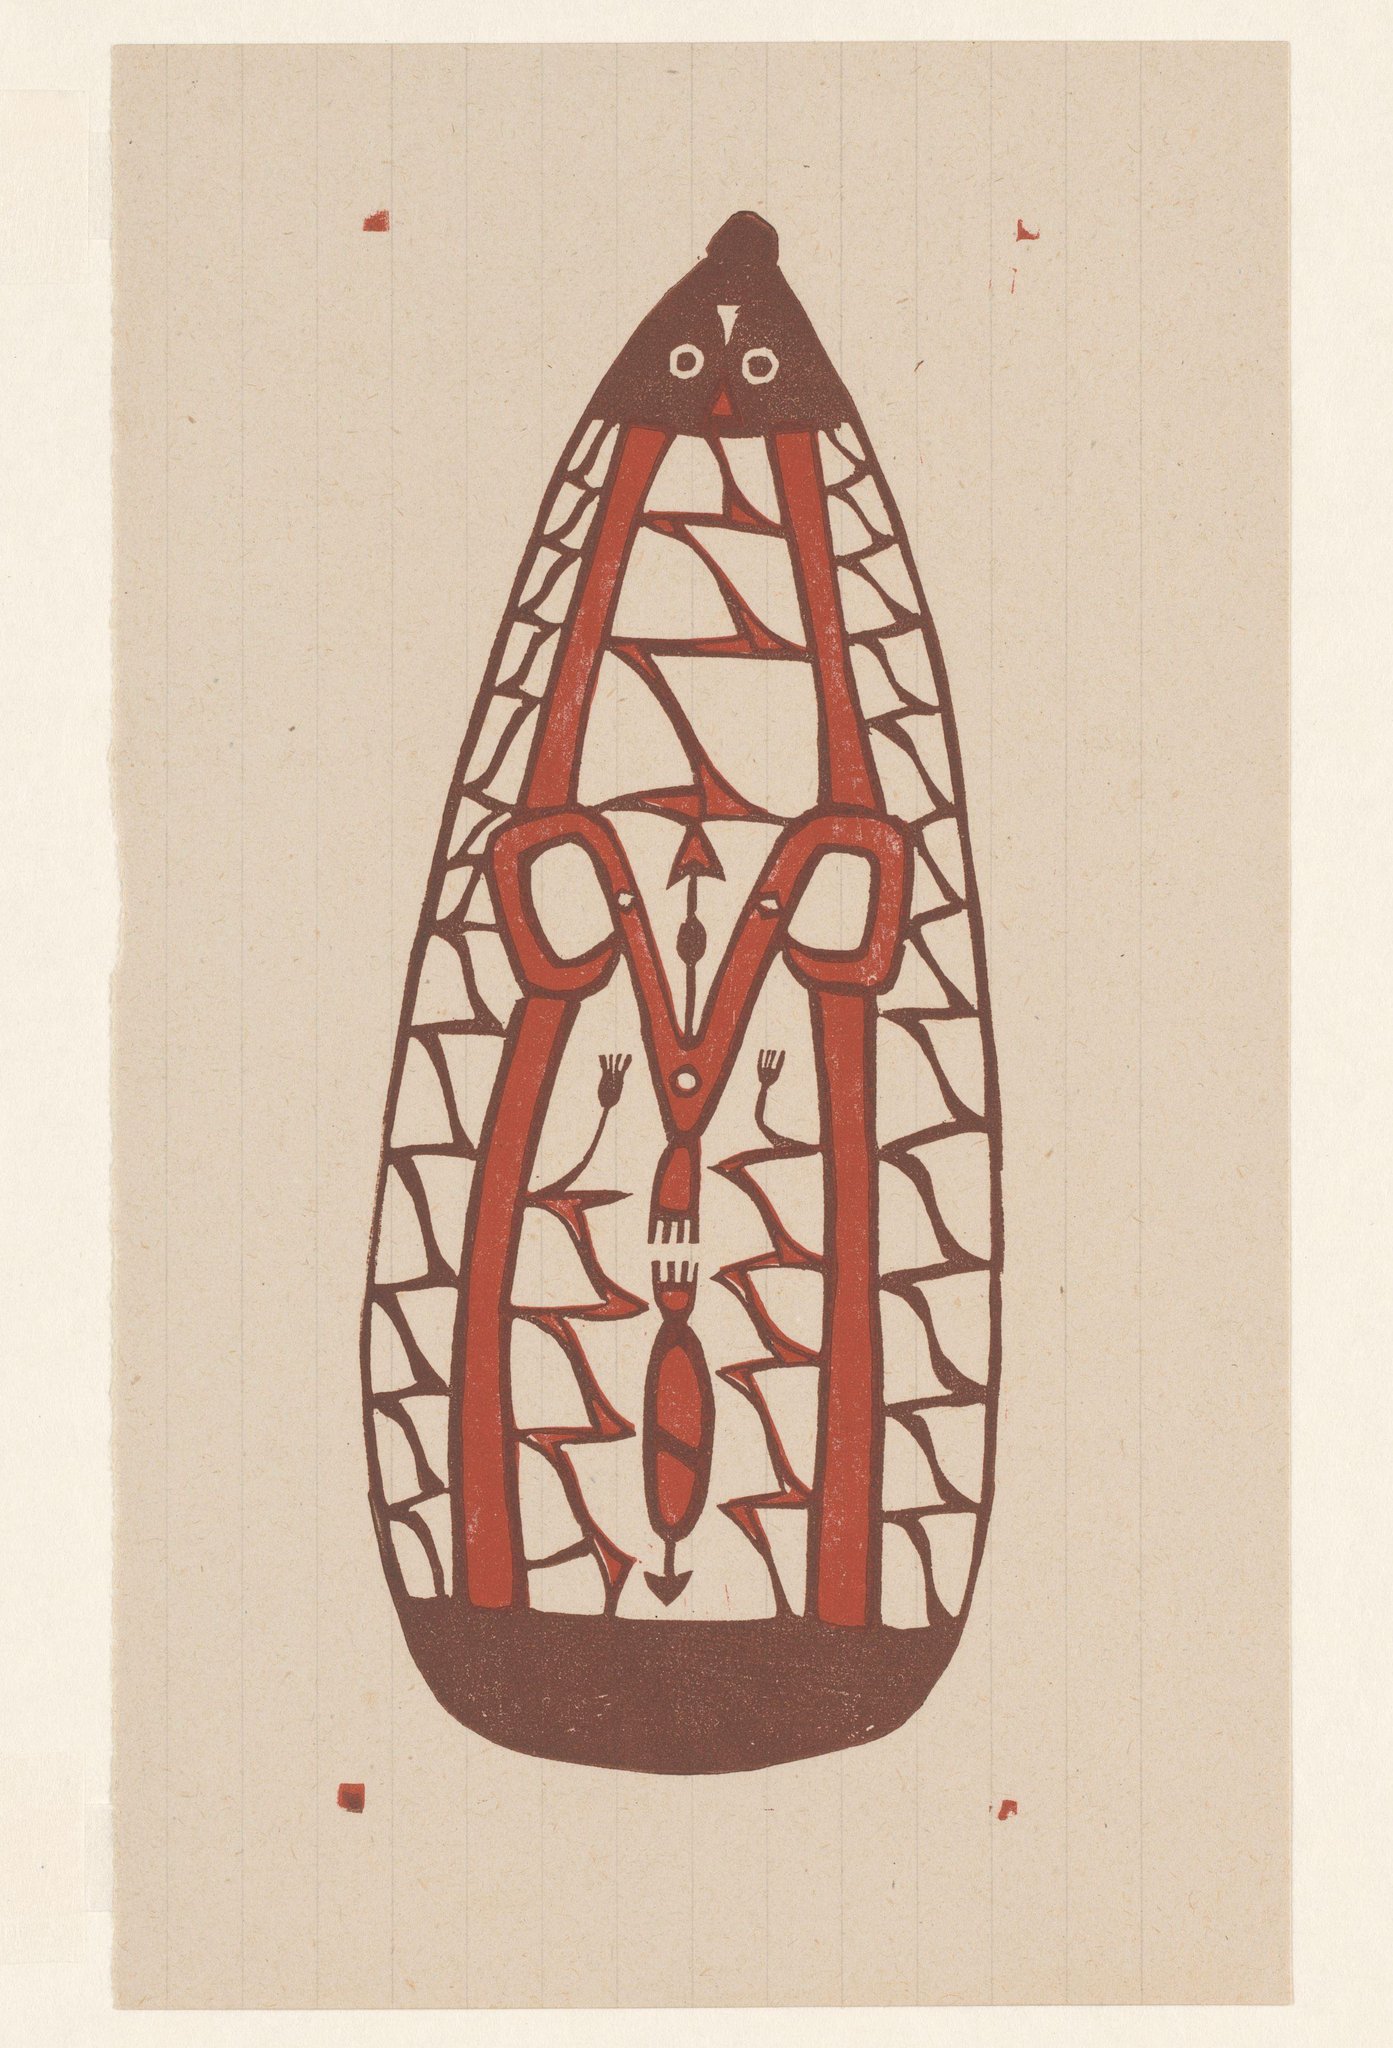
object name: print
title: Schild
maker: reijer stolk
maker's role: draughtsman, print maker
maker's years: 1896-1945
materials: lined paper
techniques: woodcut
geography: netherlands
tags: protective weapons: shield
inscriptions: collector's mark: Lugt 2228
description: Prent gebruikt voor: Reijer Stolk, Tien bladen sierkunst uit ons Oost-Indië, 1942.